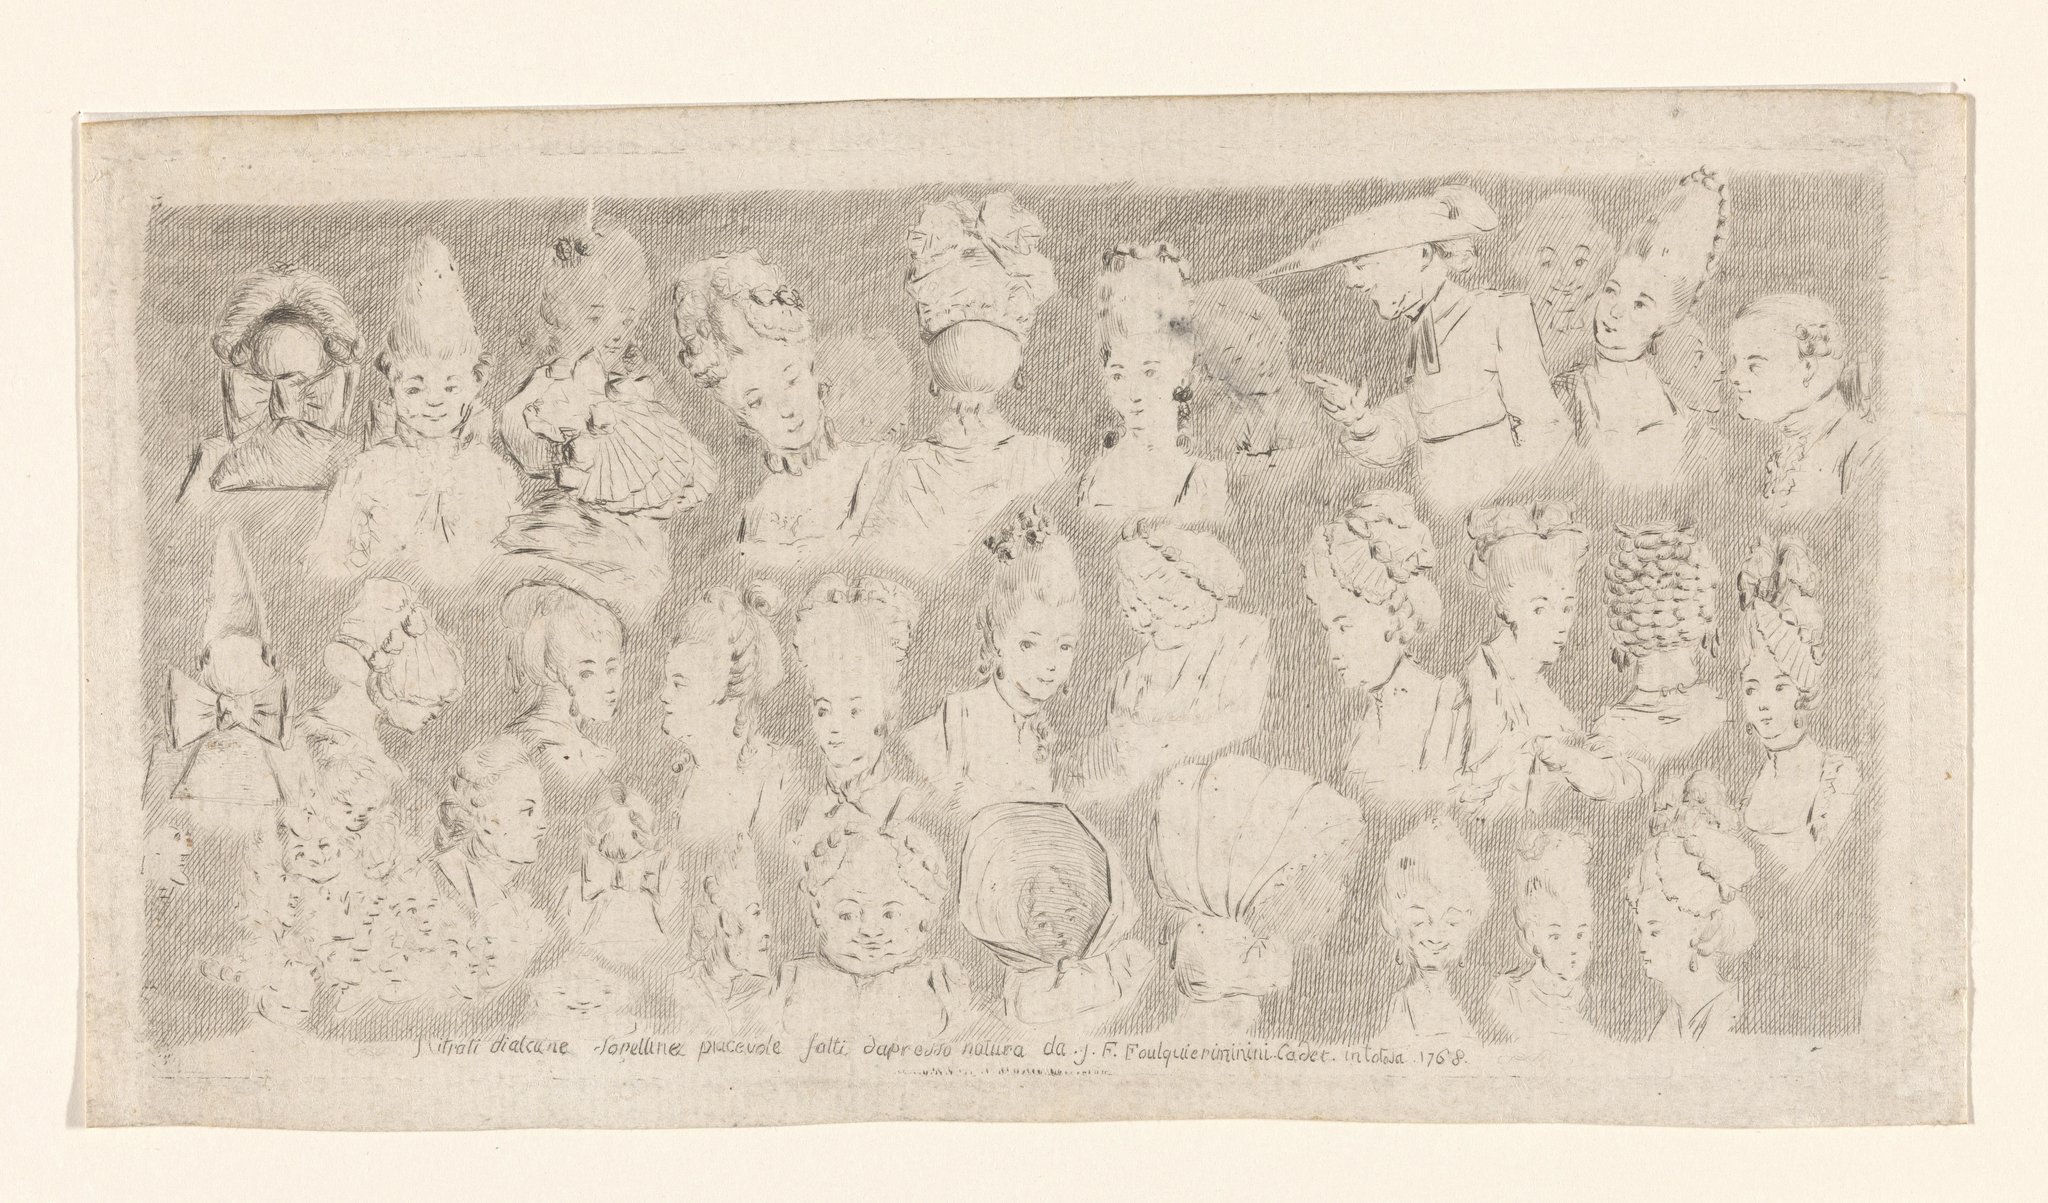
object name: print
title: Verschillende hoofden en kapsels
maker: joseph françois foulquier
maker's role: print maker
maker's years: 1744-1789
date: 1768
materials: paper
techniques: drypoint, etching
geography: rimini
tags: caricatures (human types)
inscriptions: inscription: ‘Métal Deck’, collector's mark: Lugt 2228, collector's mark: Lugt 2760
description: Studieblad met studies van hoofden van mannen en vrouwen met verschillende kapsels en hoofddeksels.